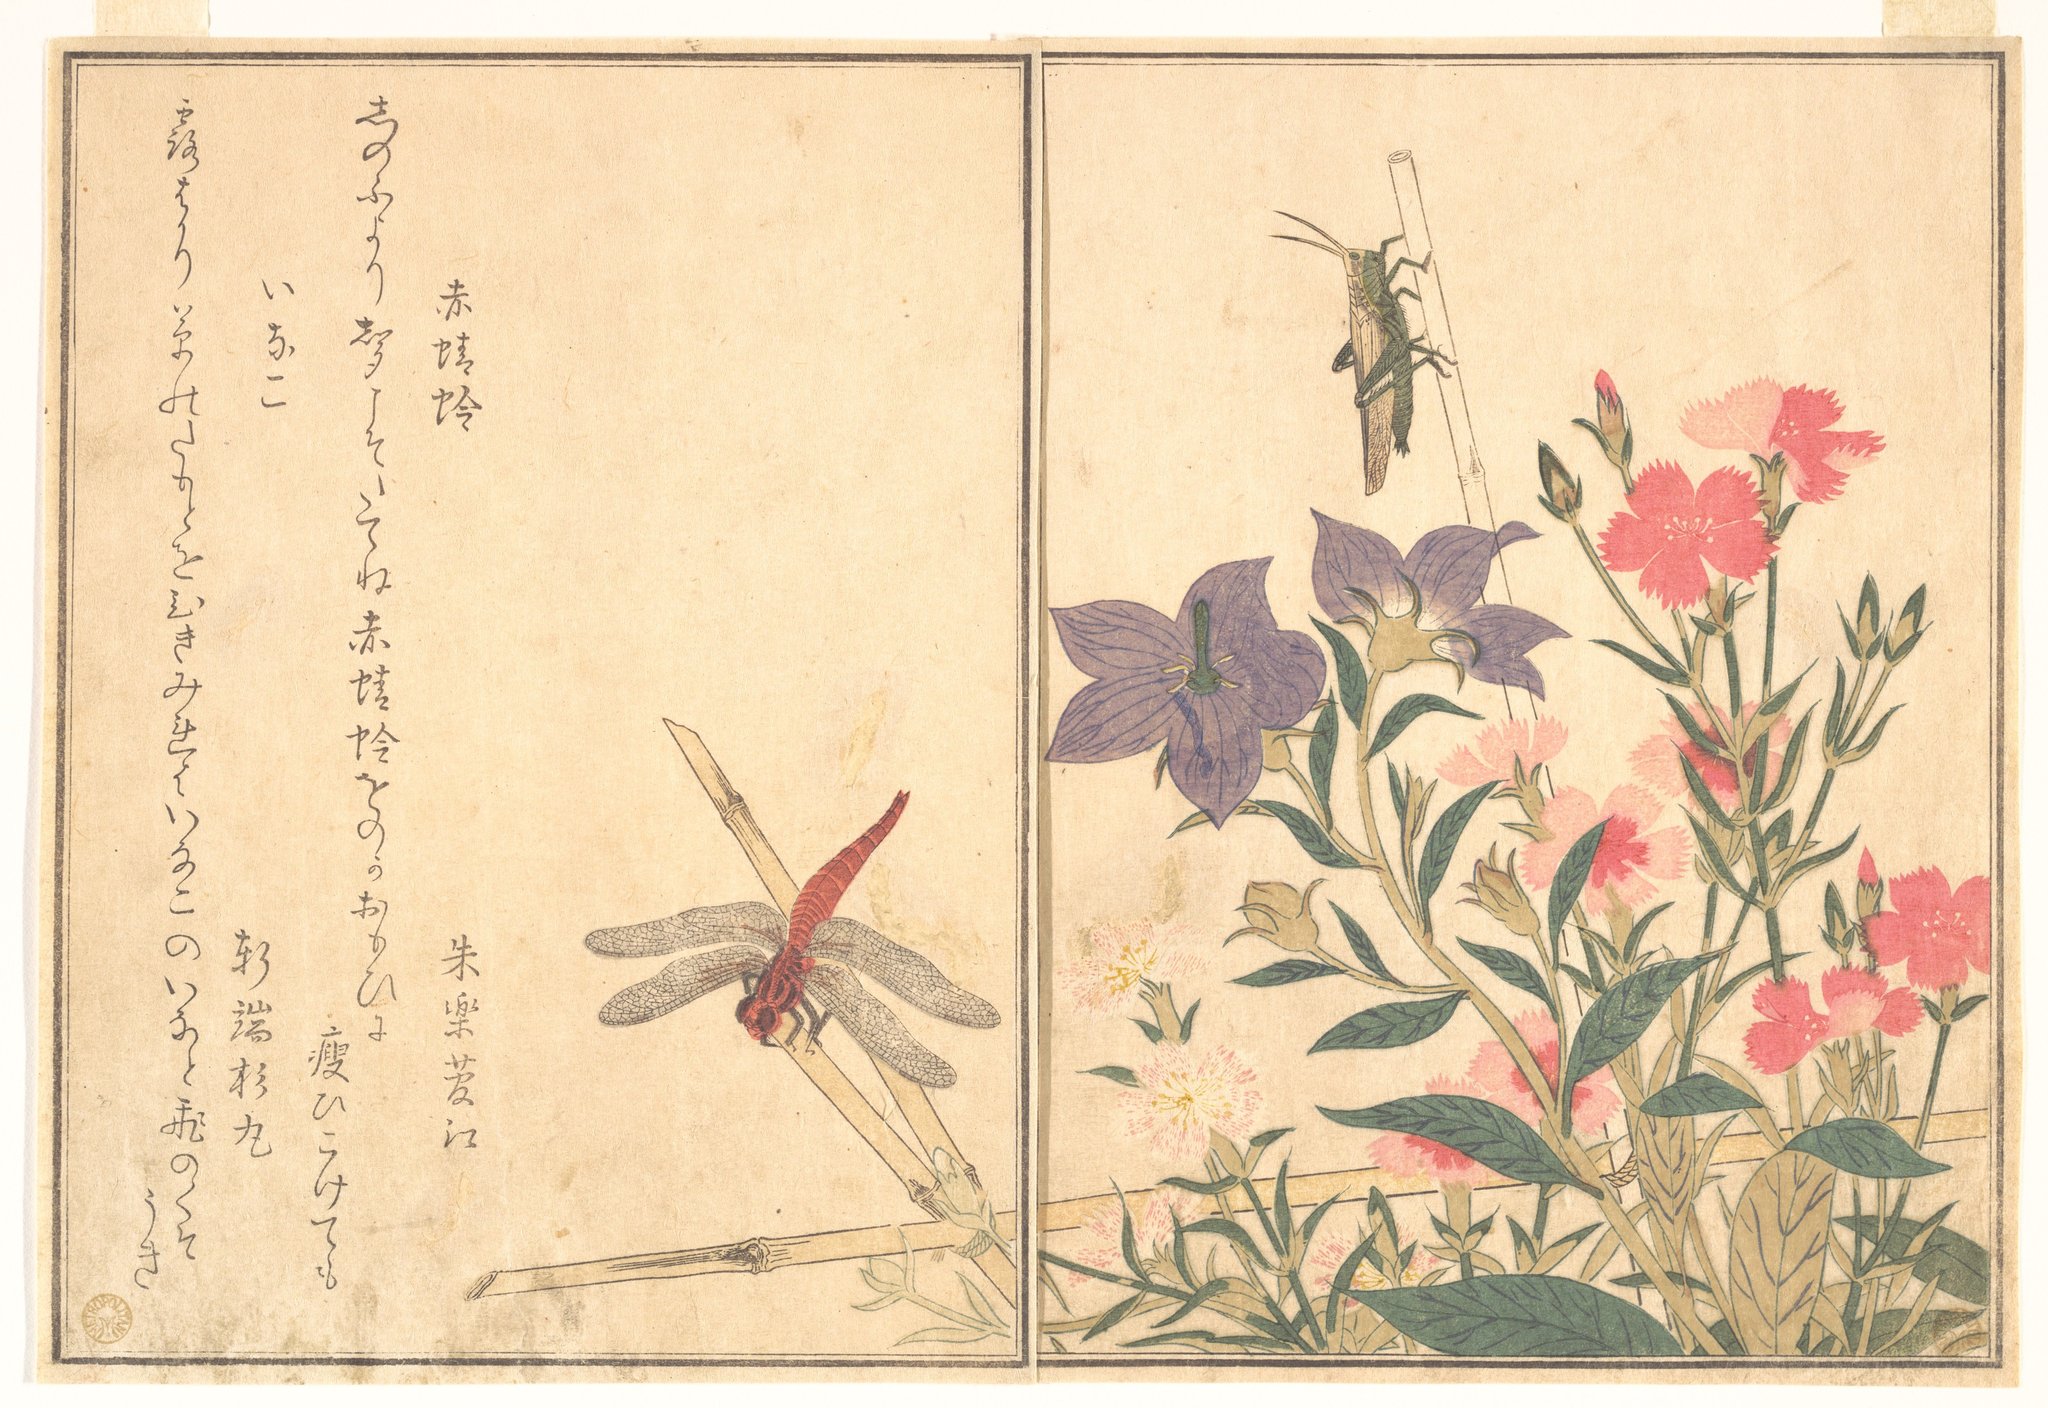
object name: woodblock print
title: Red Dragonfly (Akatonbo); Locust (Inago), from the Picture Book of Crawling Creatures (Ehon mushi erami)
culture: japanese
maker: kitagawa utamaro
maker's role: artist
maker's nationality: japanese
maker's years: 1754-1806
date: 1788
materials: ink, paper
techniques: woodblock print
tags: insects,dragonflies,flowers,plants